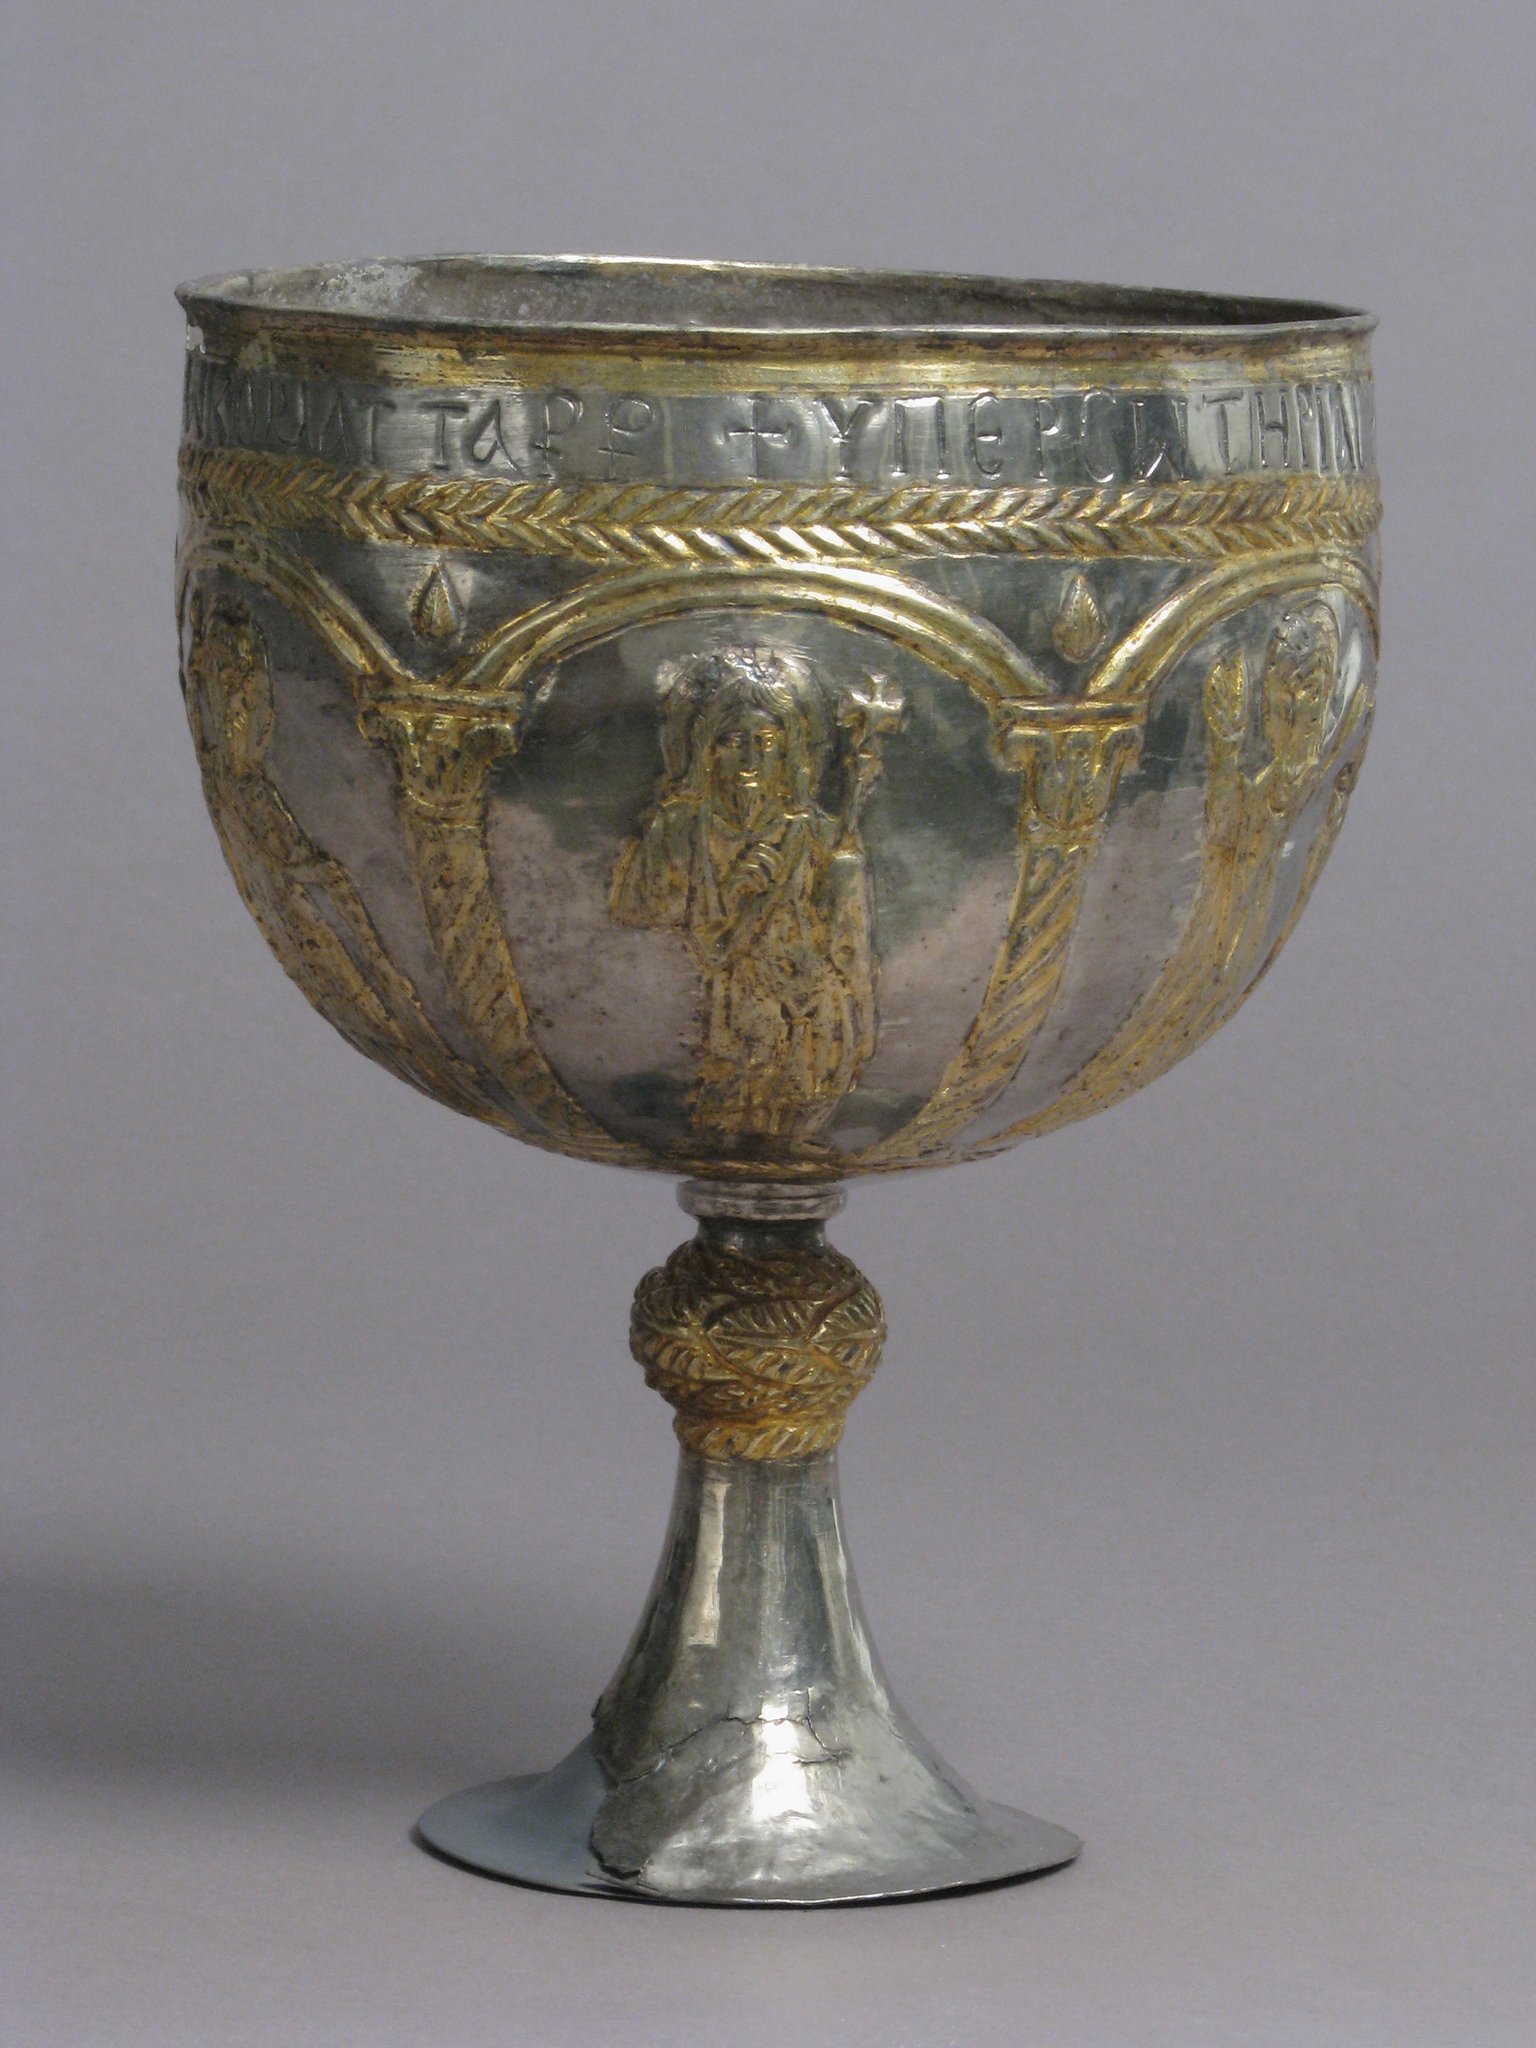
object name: chalice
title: The Attarouthi Treasure - Chalice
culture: byzantine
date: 500-650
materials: gilt silver, silver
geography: syria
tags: virgin mary